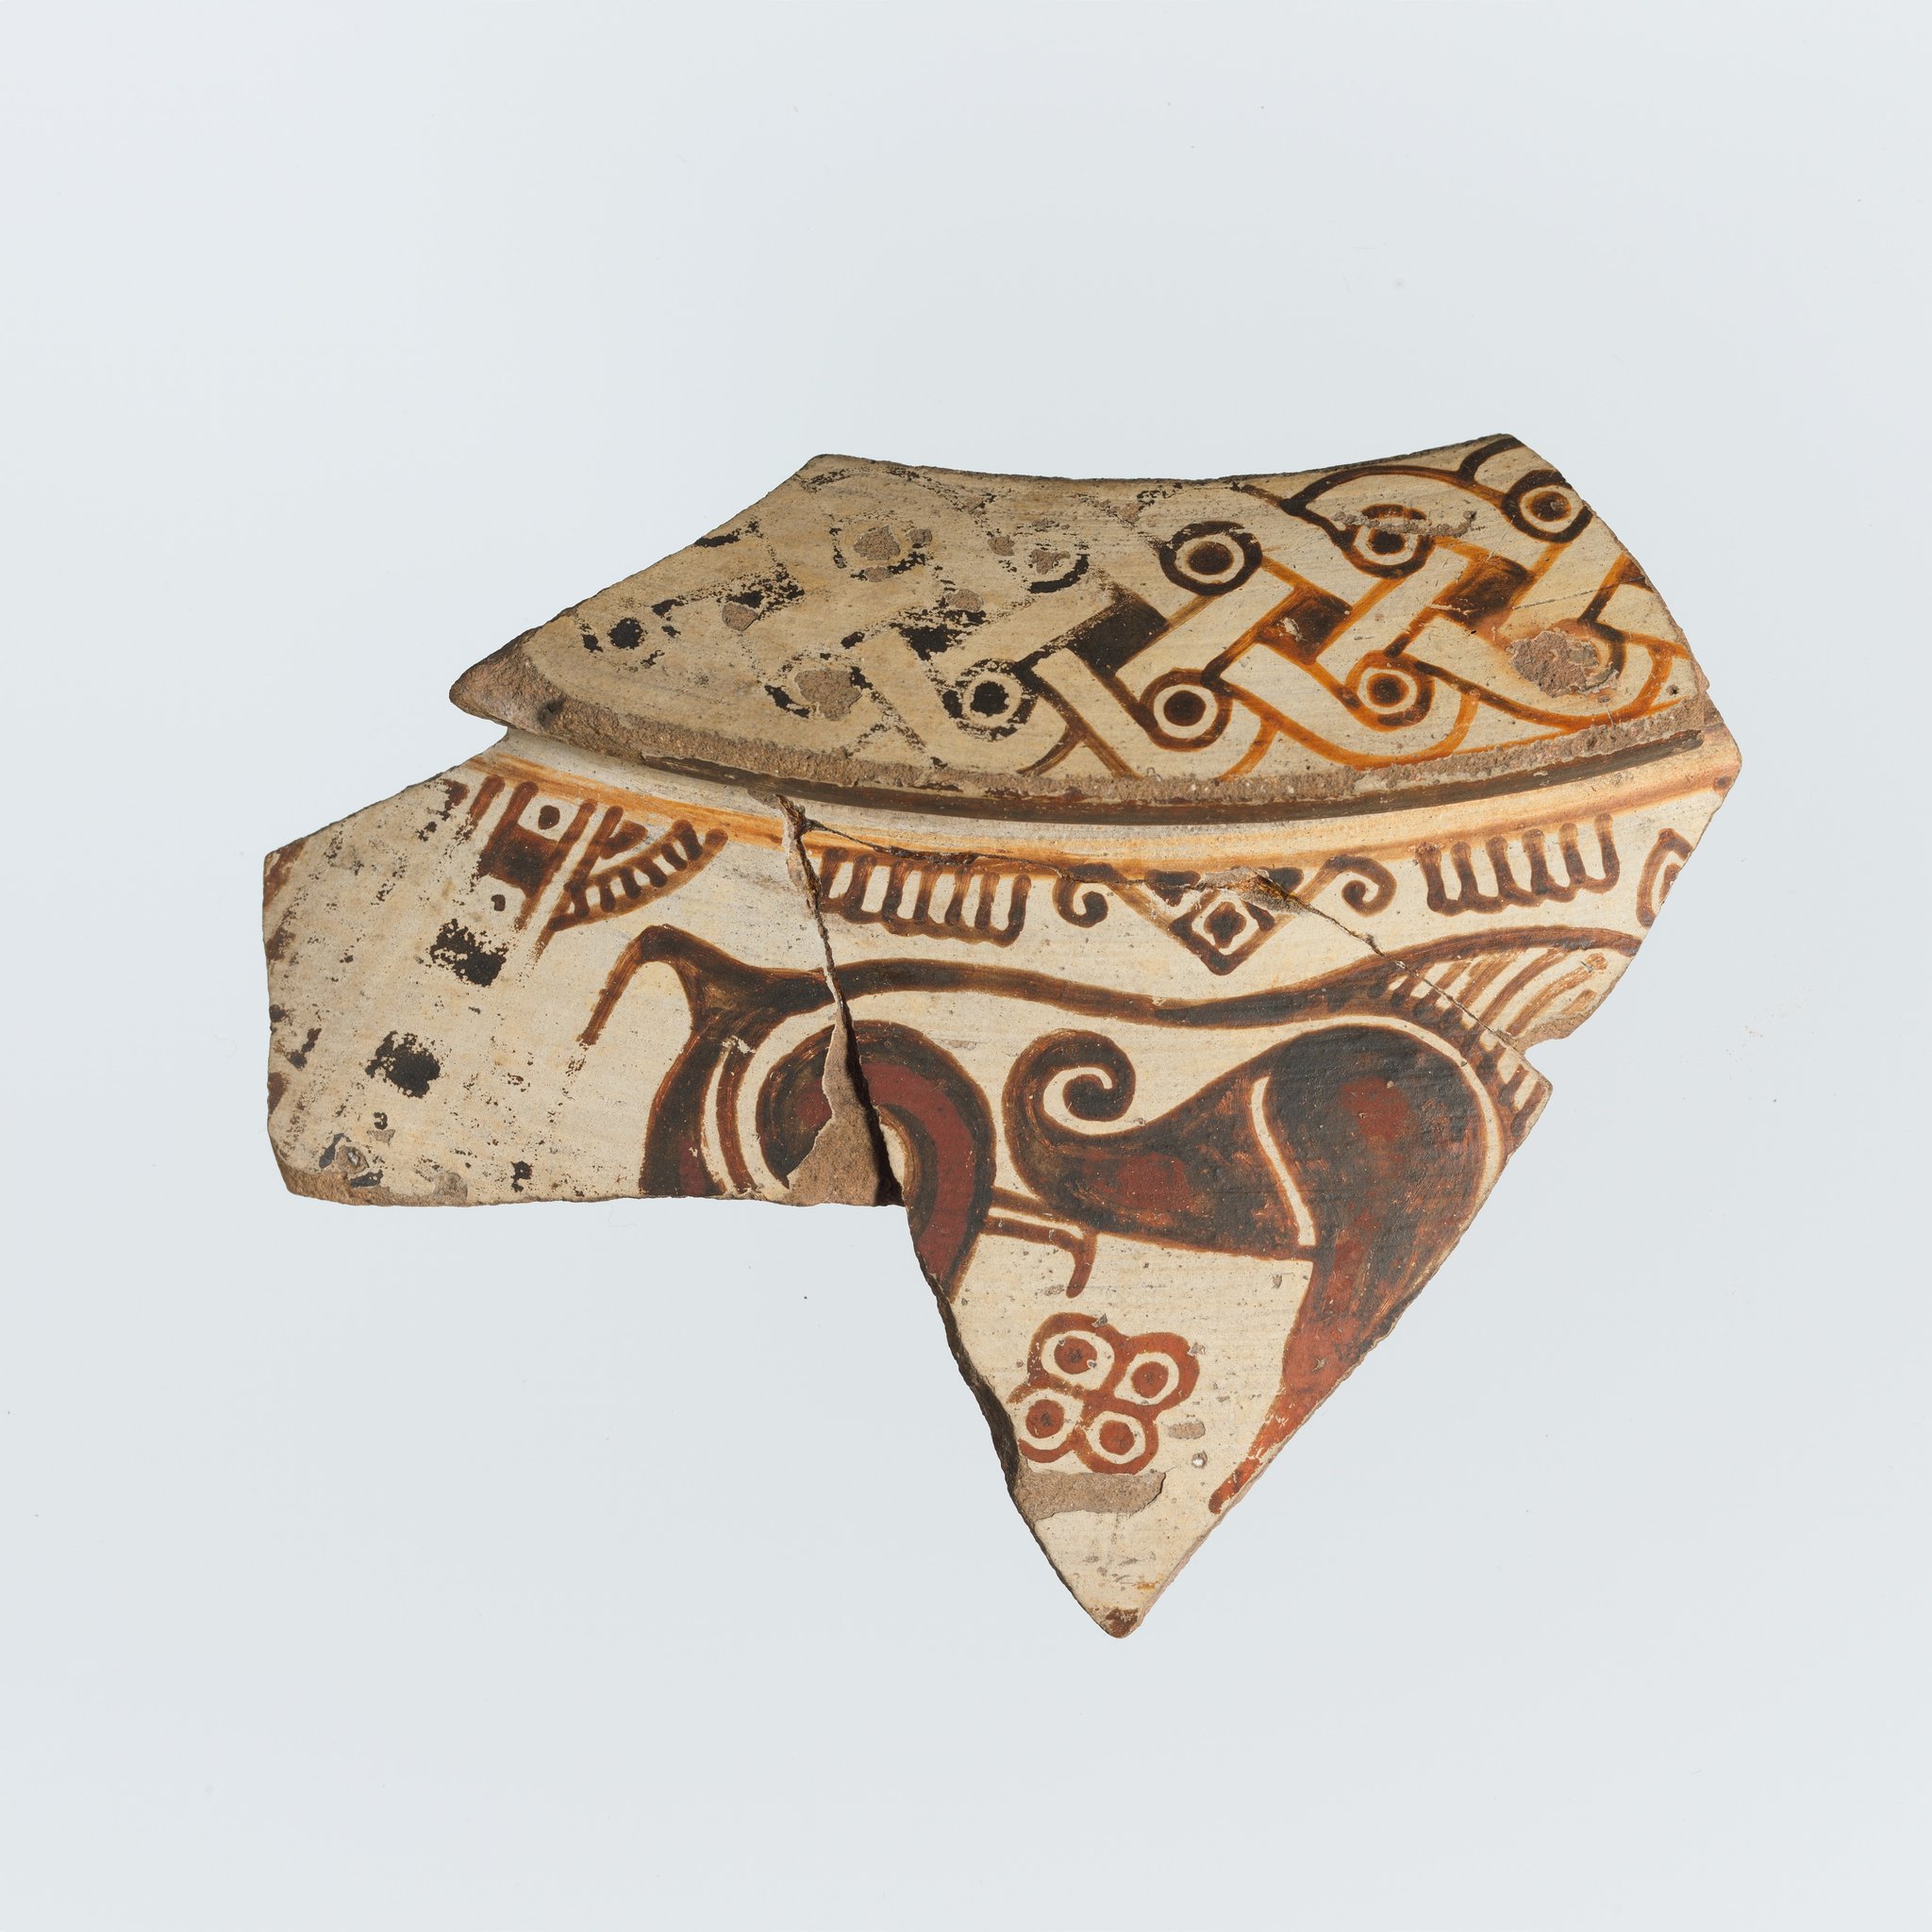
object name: dinos fragment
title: Fragment of a terracotta dinos (deep round-bottomed bowl)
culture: east greek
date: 600 BCE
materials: terracotta